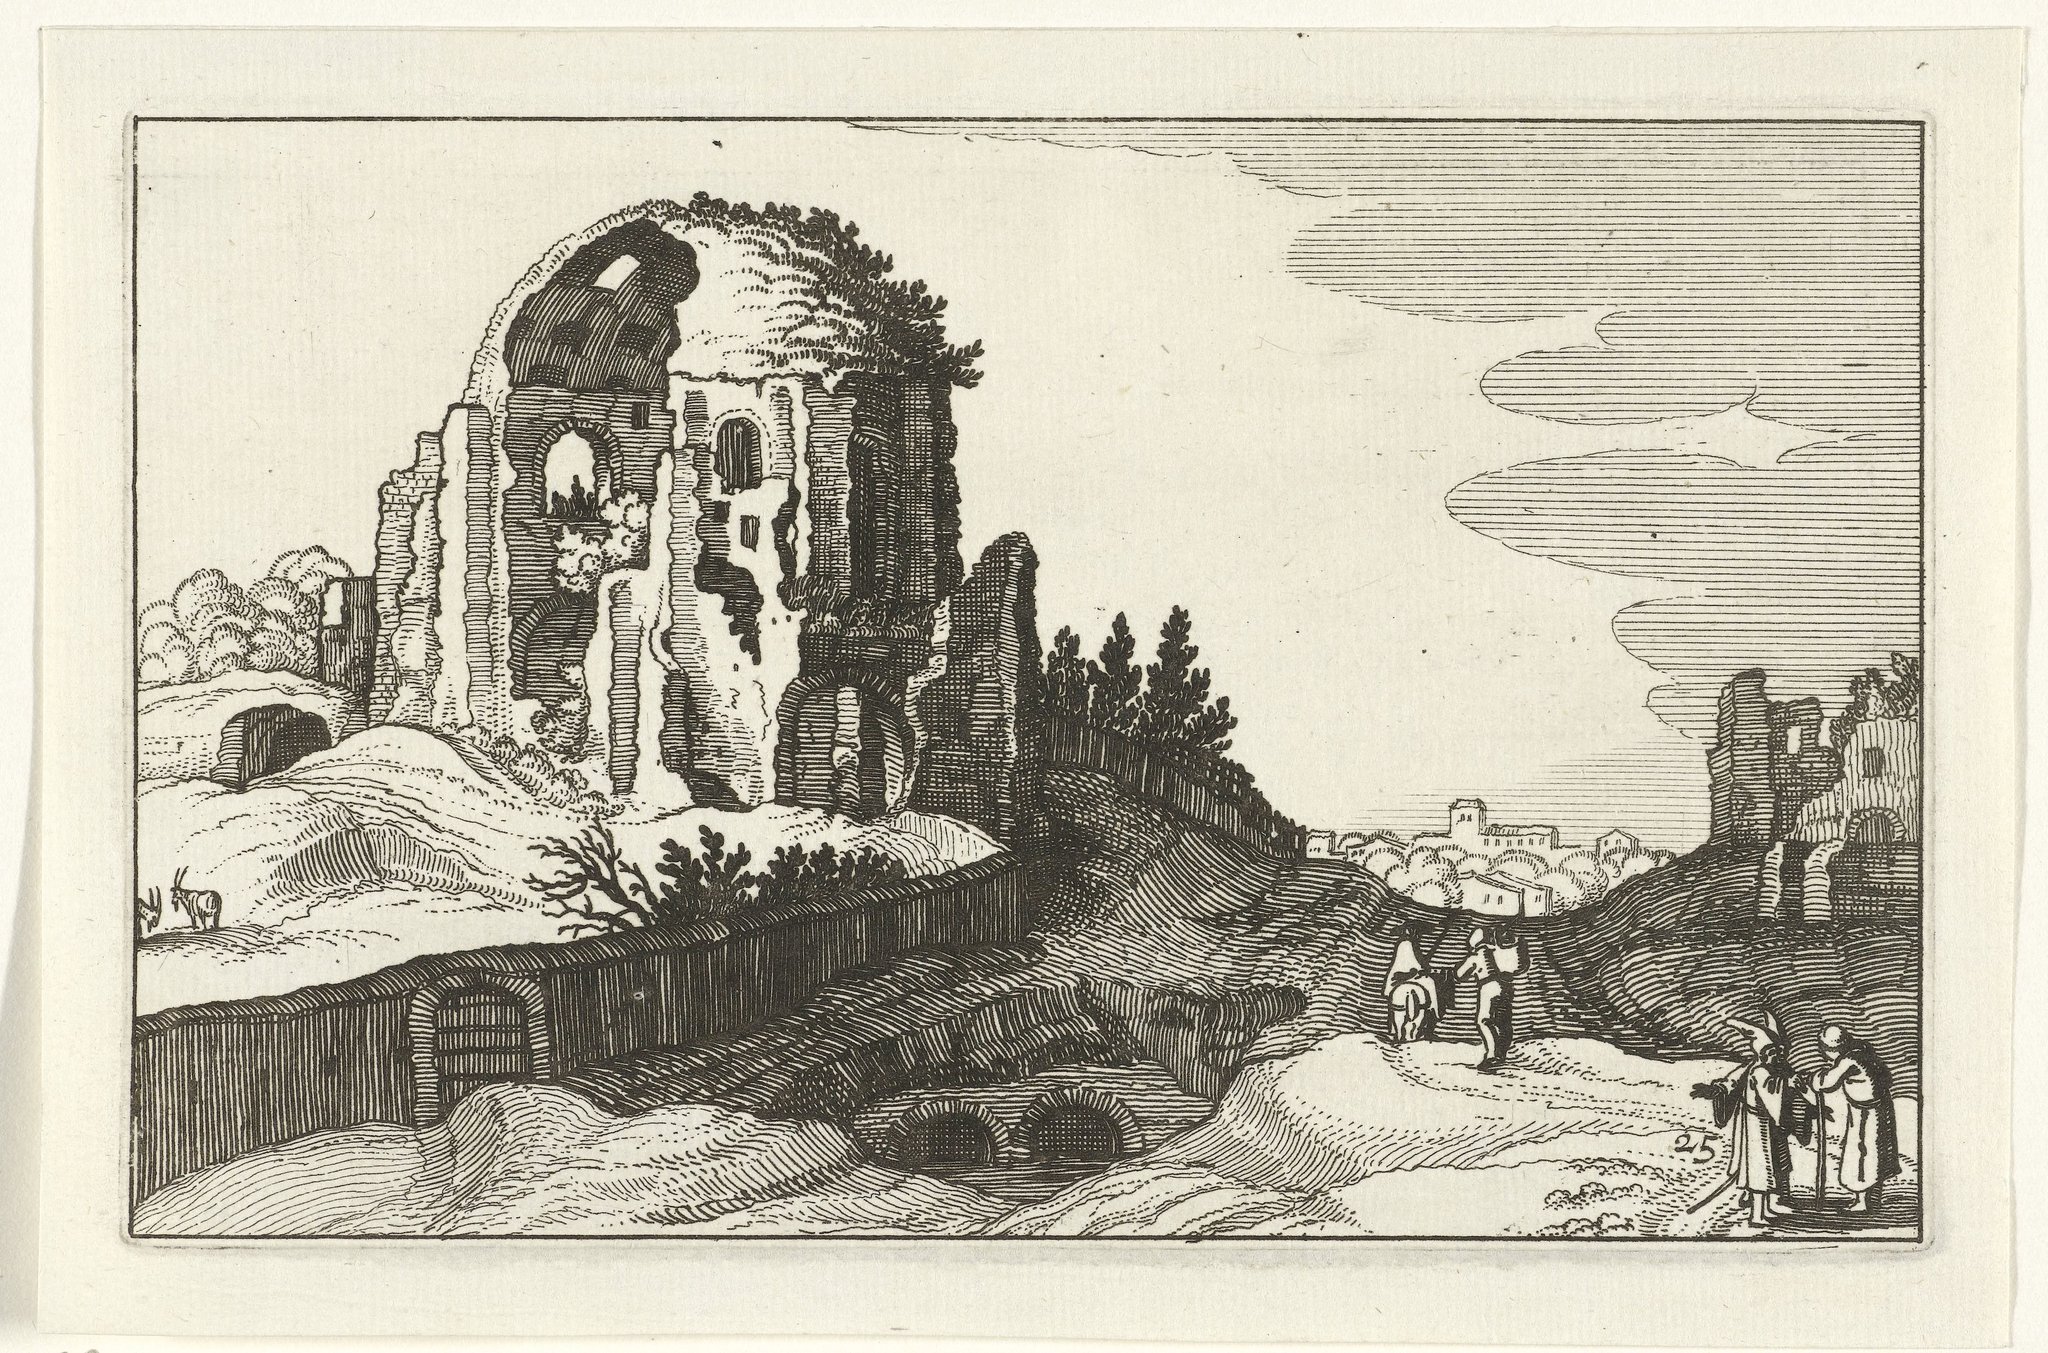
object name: print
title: Romeinse ruïnes en kustlandschappen (serie 1)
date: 1618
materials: paper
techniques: etching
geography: amsterdam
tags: landscape with ruins, rome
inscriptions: collector's mark: Lugt 2228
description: De ruïne van het nymphaeum, ook bekend als de tempel van Minerva Medica, in Rome. Rechts een weg met enkele reizigers. Prent maakt deel uit van een serie Romeinse ruïnes en kustlandschappen naar een prentserie van Willem van Nieulandt.